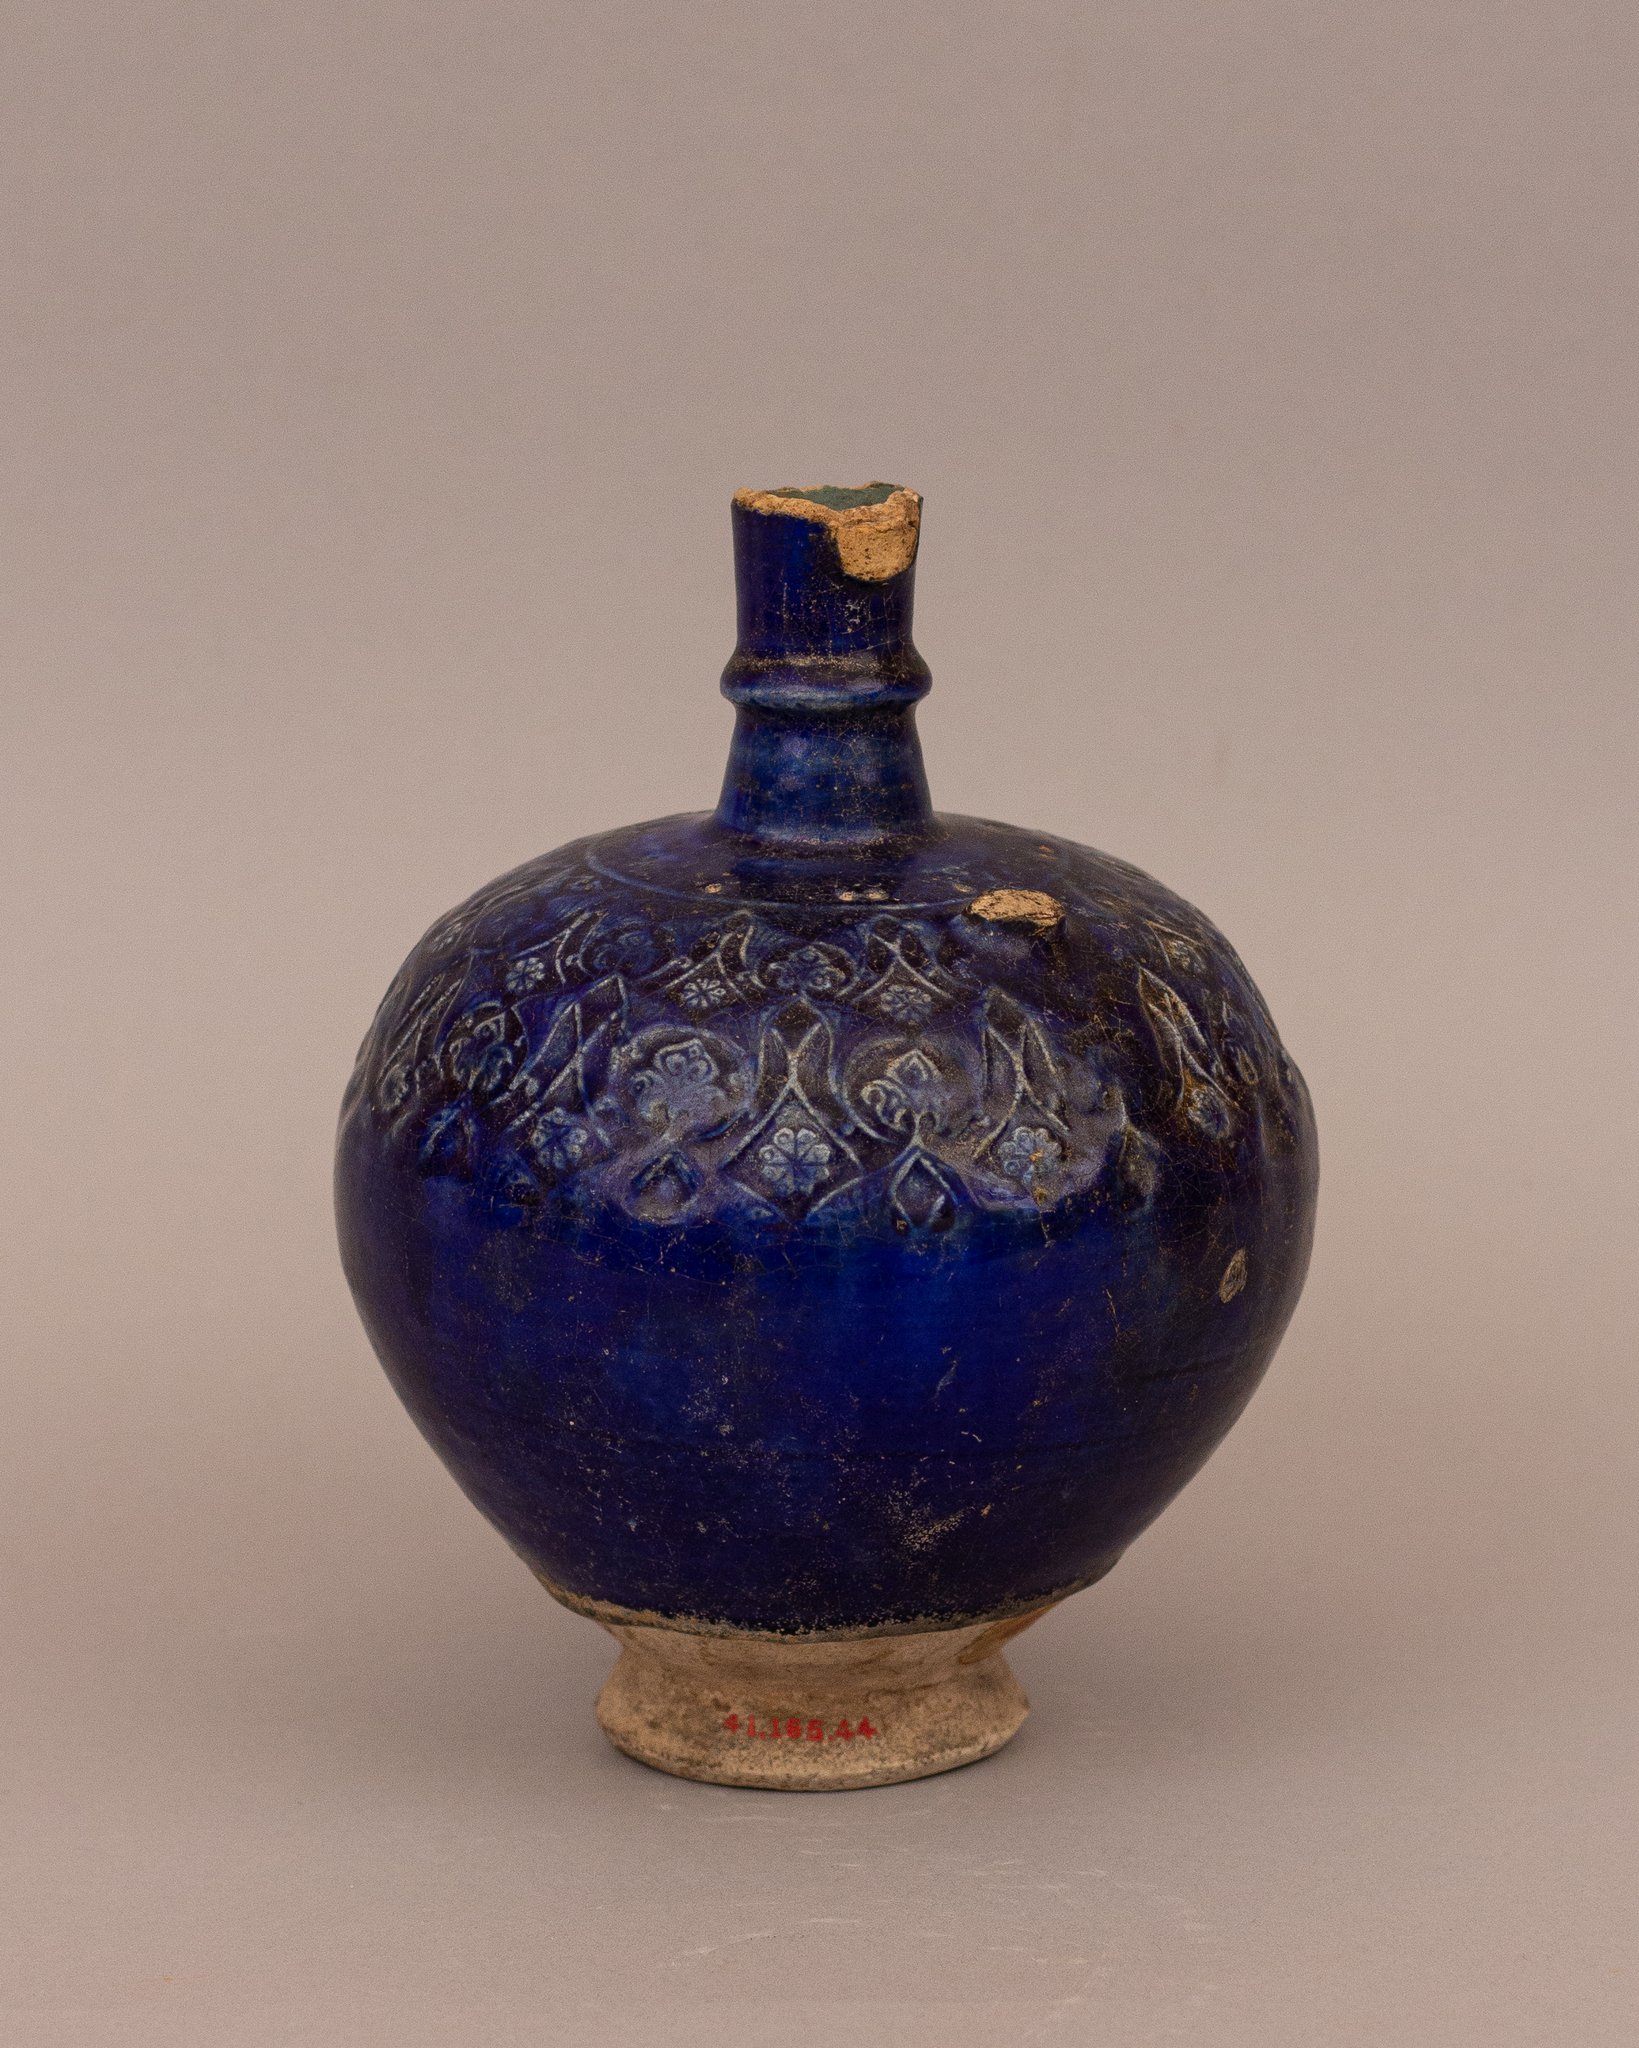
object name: ewer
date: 1101-1300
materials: earthenware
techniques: glazing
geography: iran